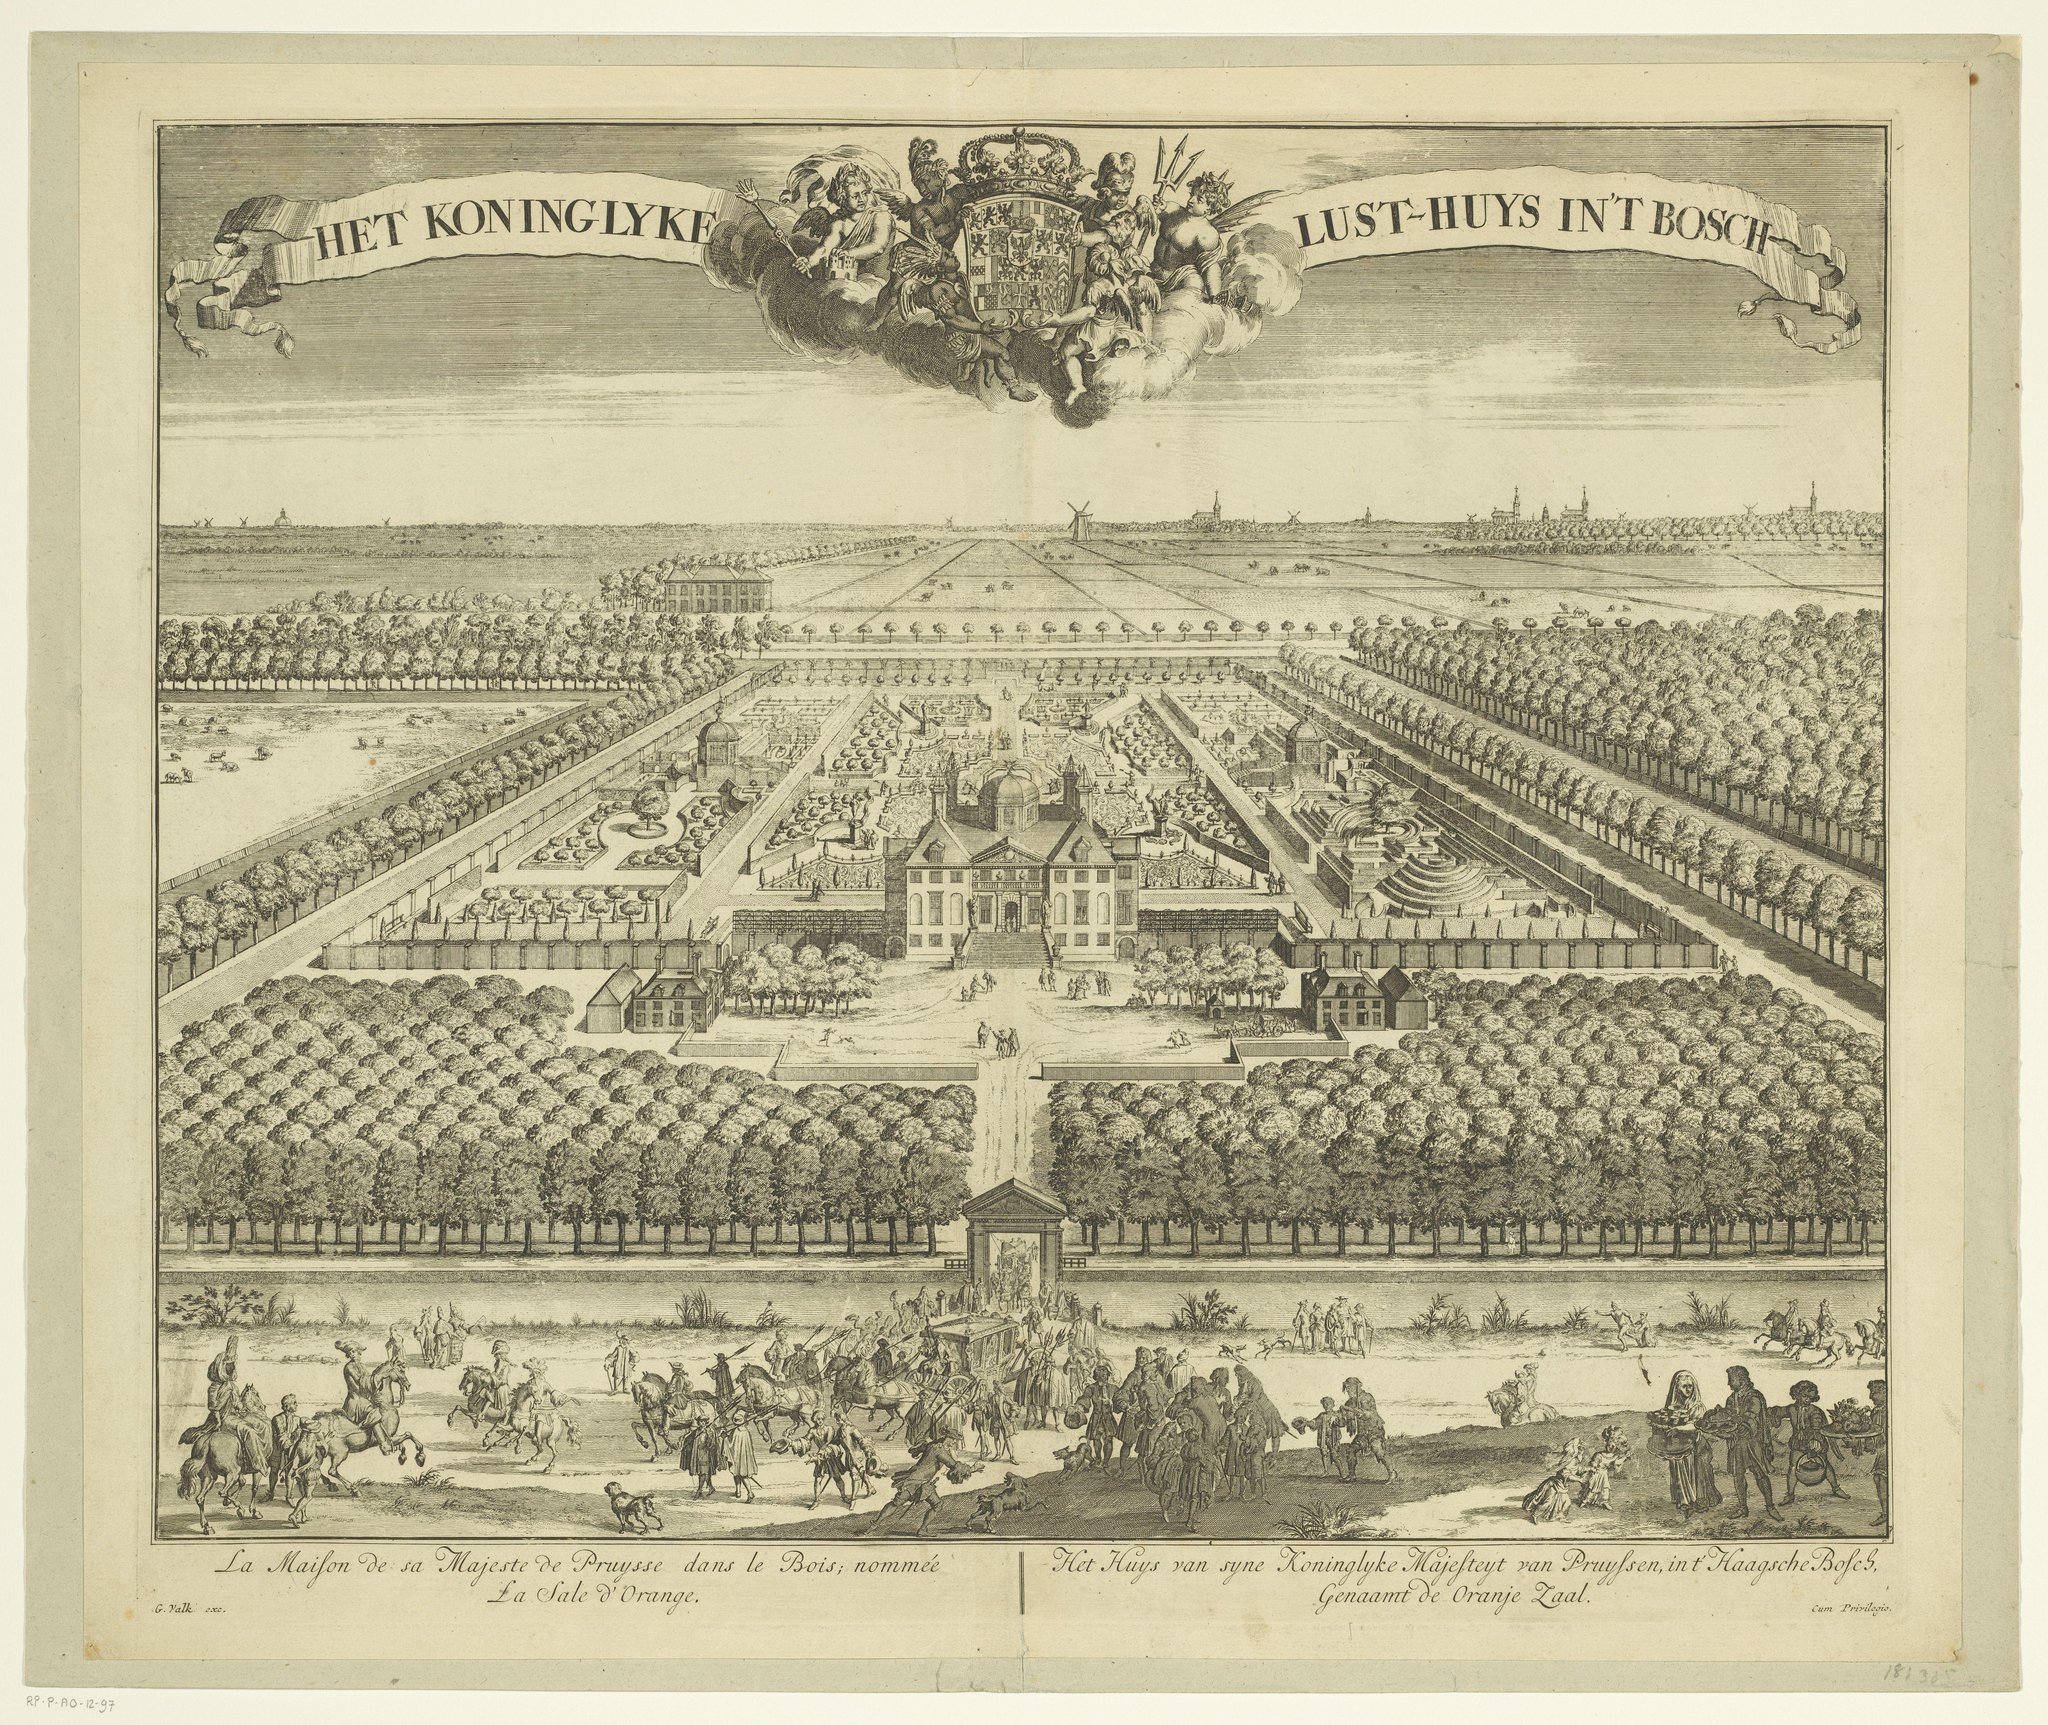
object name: print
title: Vogelvluchtgezicht op paleis Huis ten Bosch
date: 1702-1717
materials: paper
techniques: engraving, etching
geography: amsterdam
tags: coat of arms (as symbol of the state, etc.) (+ city; municipal), palace, french or architectonic garden; formal garden, armorial bearing, heraldry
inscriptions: collector's mark: Lugt 2228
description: Vogelvluchtgezicht op paleis Huis ten Bosch, destijds bekend als de Oranjezaal. Boven in het midden het wapen van Frederik Willem I van Pruisen, die in 1702 na het overlijden van Willem III van Oranje het paleis erfde.